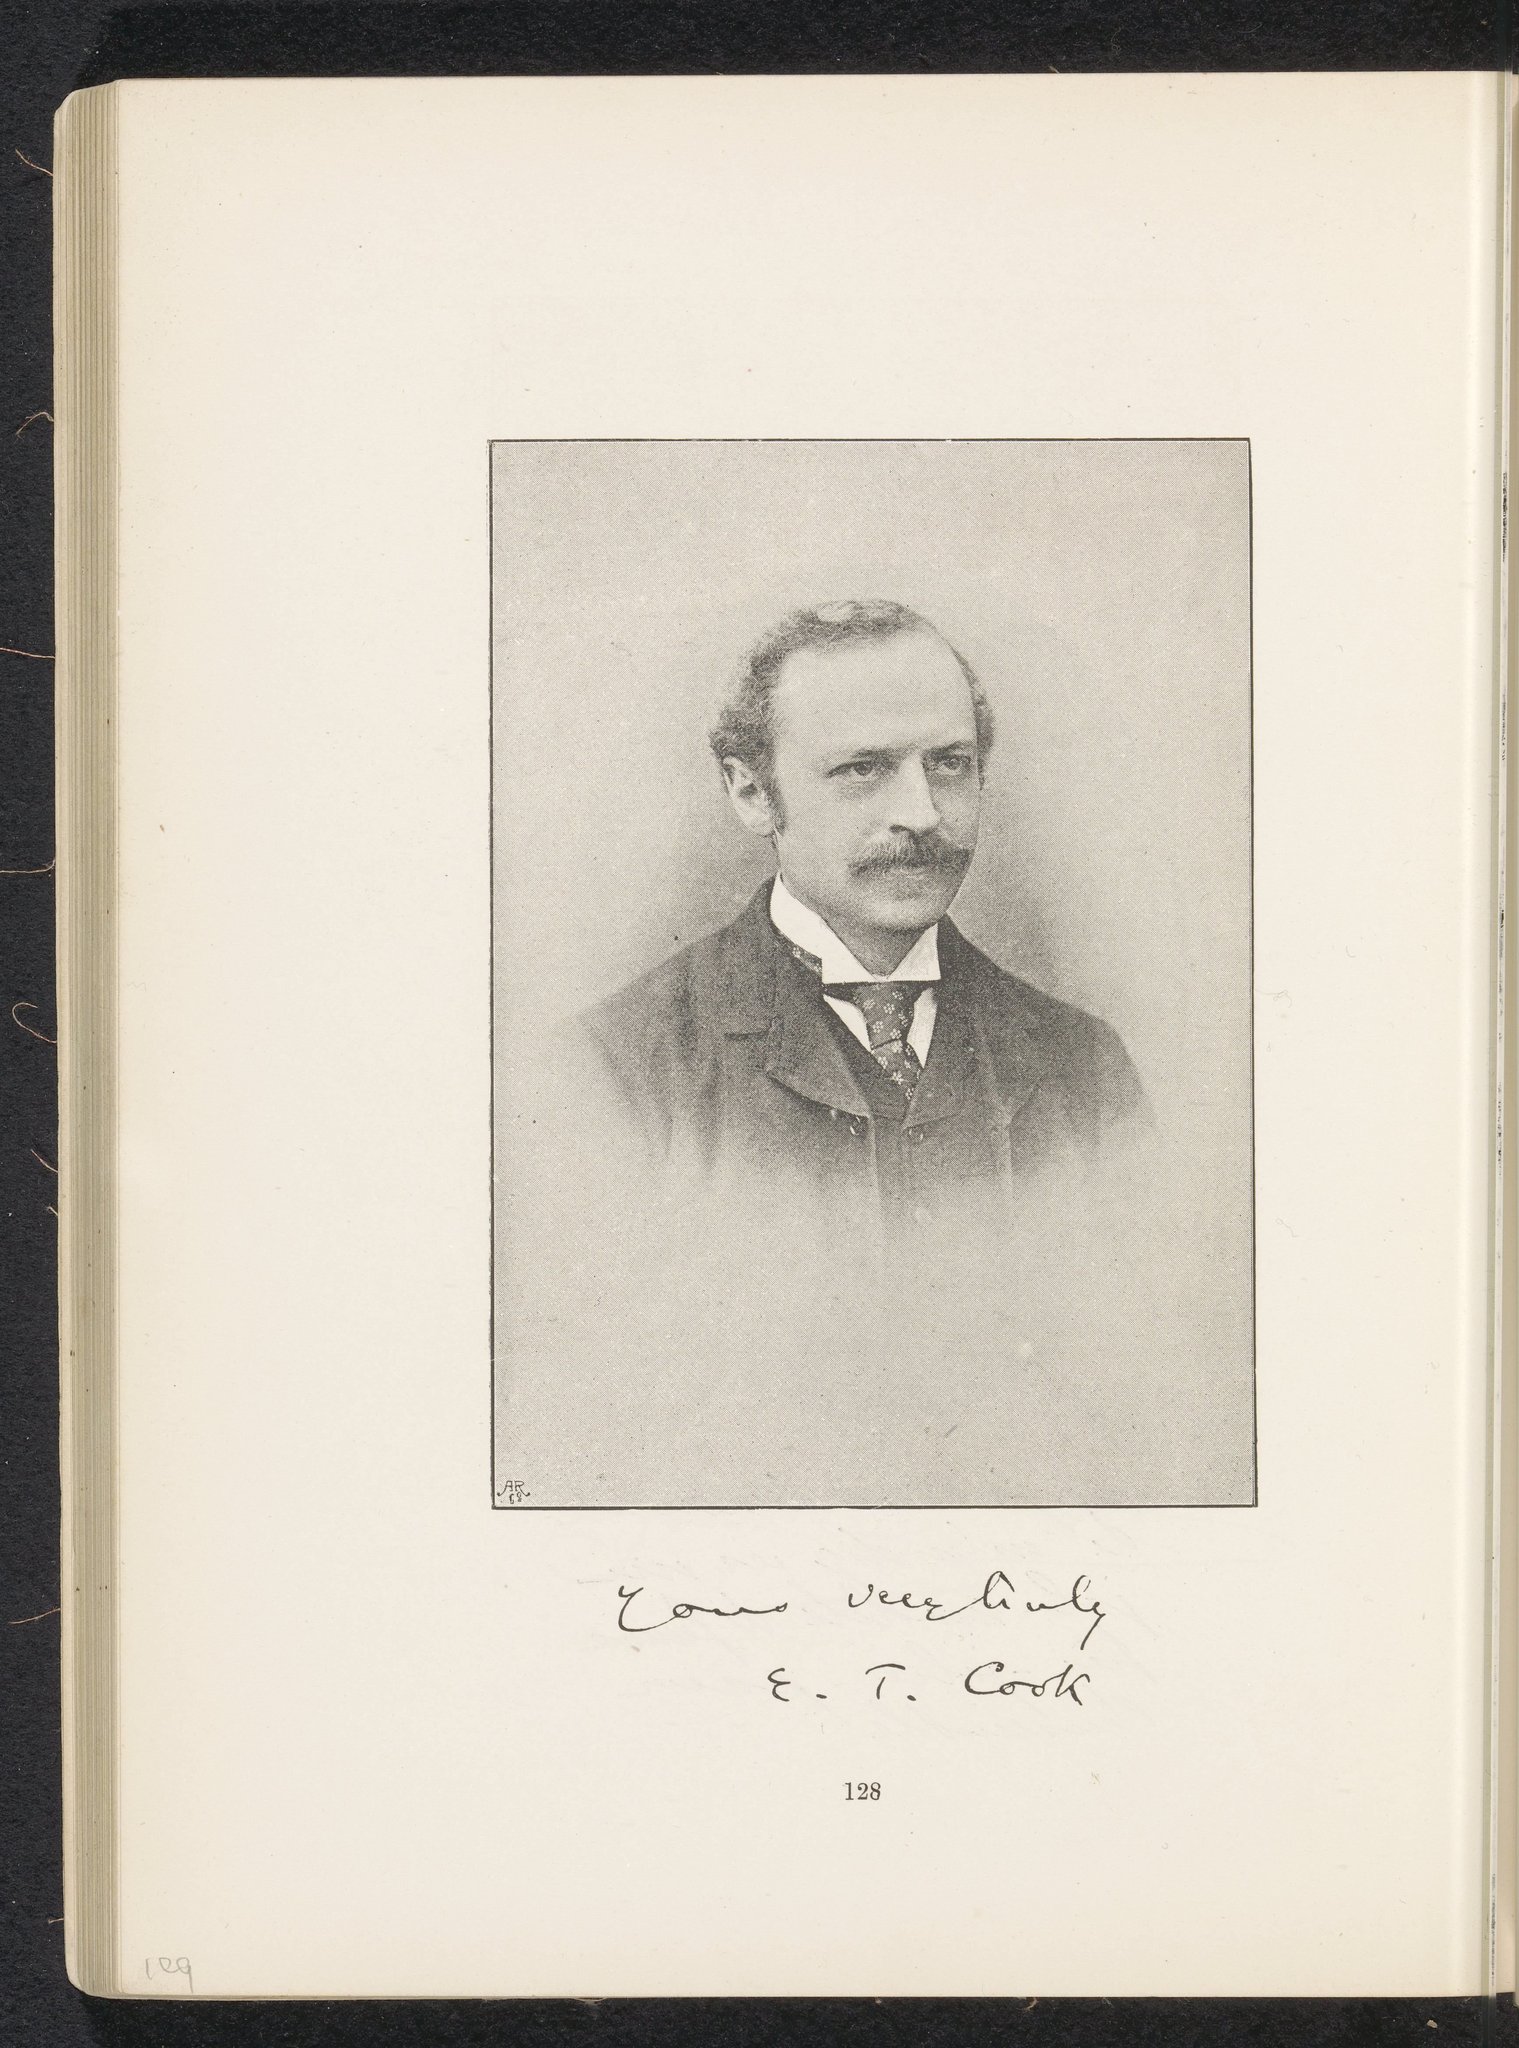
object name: photomechanical print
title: Portret van Edward T. Cook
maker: Anonymous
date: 1881-1891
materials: paper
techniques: autotype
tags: historical persons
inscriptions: inscription